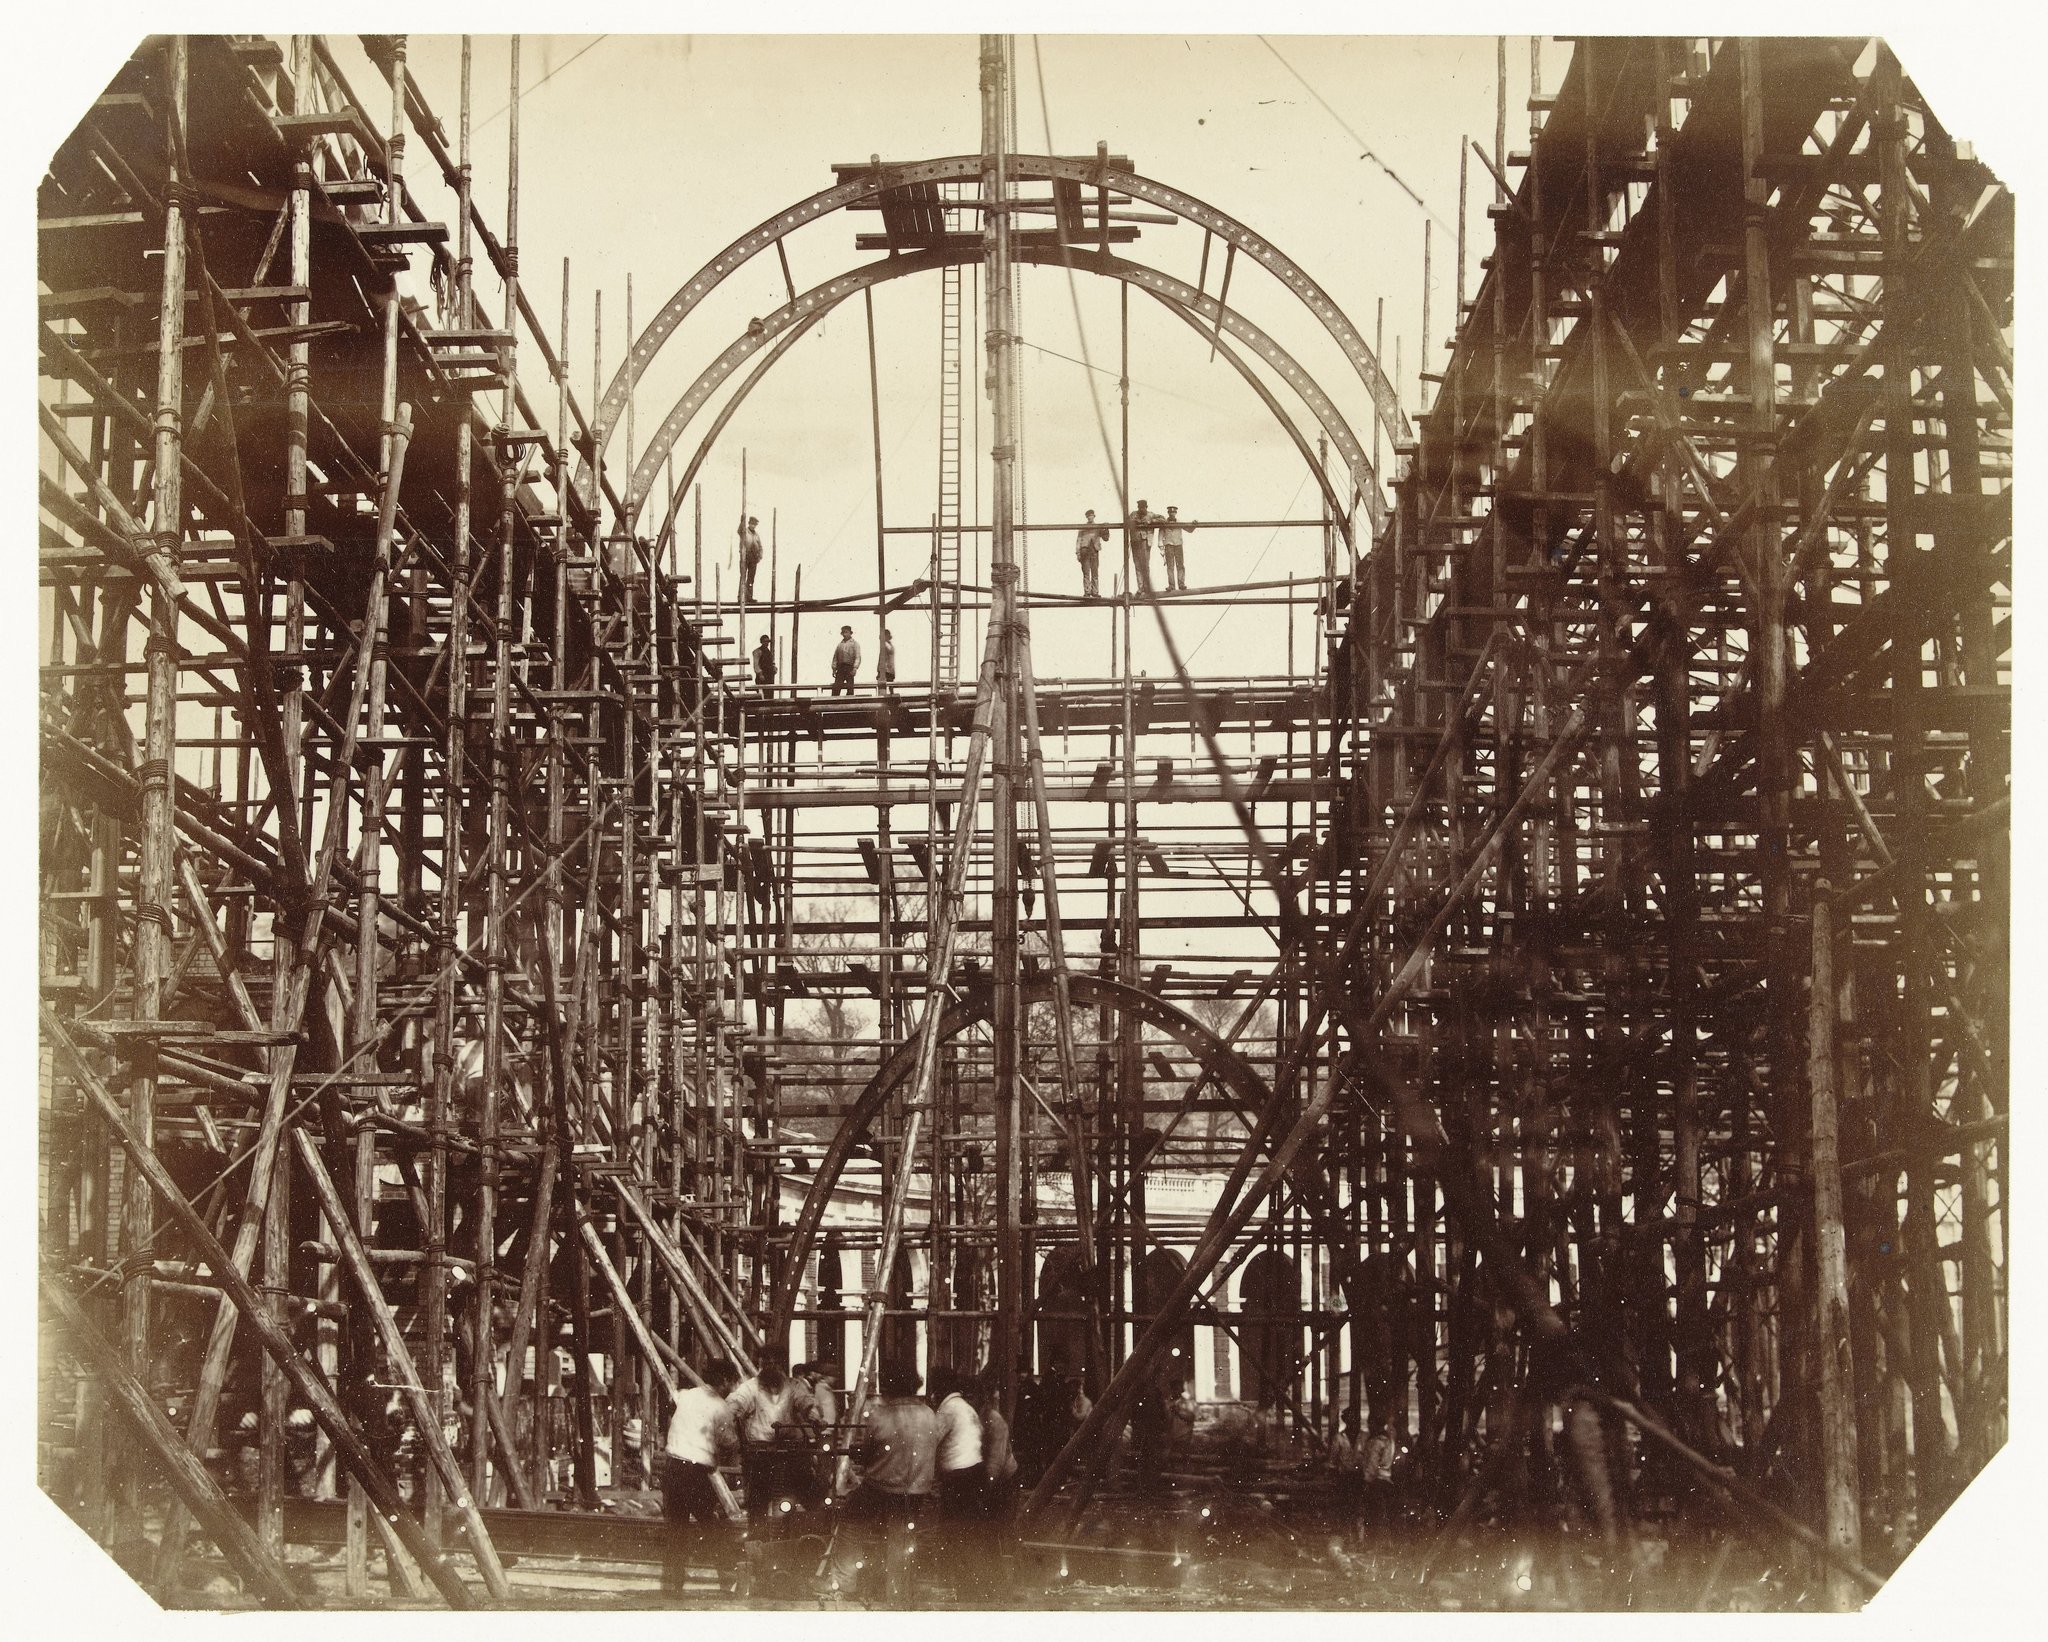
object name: photograph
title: Construction of the International Exhibition Building in London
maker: benjamin l. spackman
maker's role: fotograaf, korporaal, sergeant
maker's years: 1824-1879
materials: paper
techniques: albumen print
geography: london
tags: world fair, world exhibition, building-site, london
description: The International Exhibition held in London in 1862 drew more than six million visitors in a six-month period. Among the 28,000 individuals and firms promoting their products there was Benjamin Spackman. He had learned how to take photographs a few years earlier and recorded the construction of the South Kensington Museum. Included in the photographs he displayed were ones he had taken of the construction of the vast exhibition building.